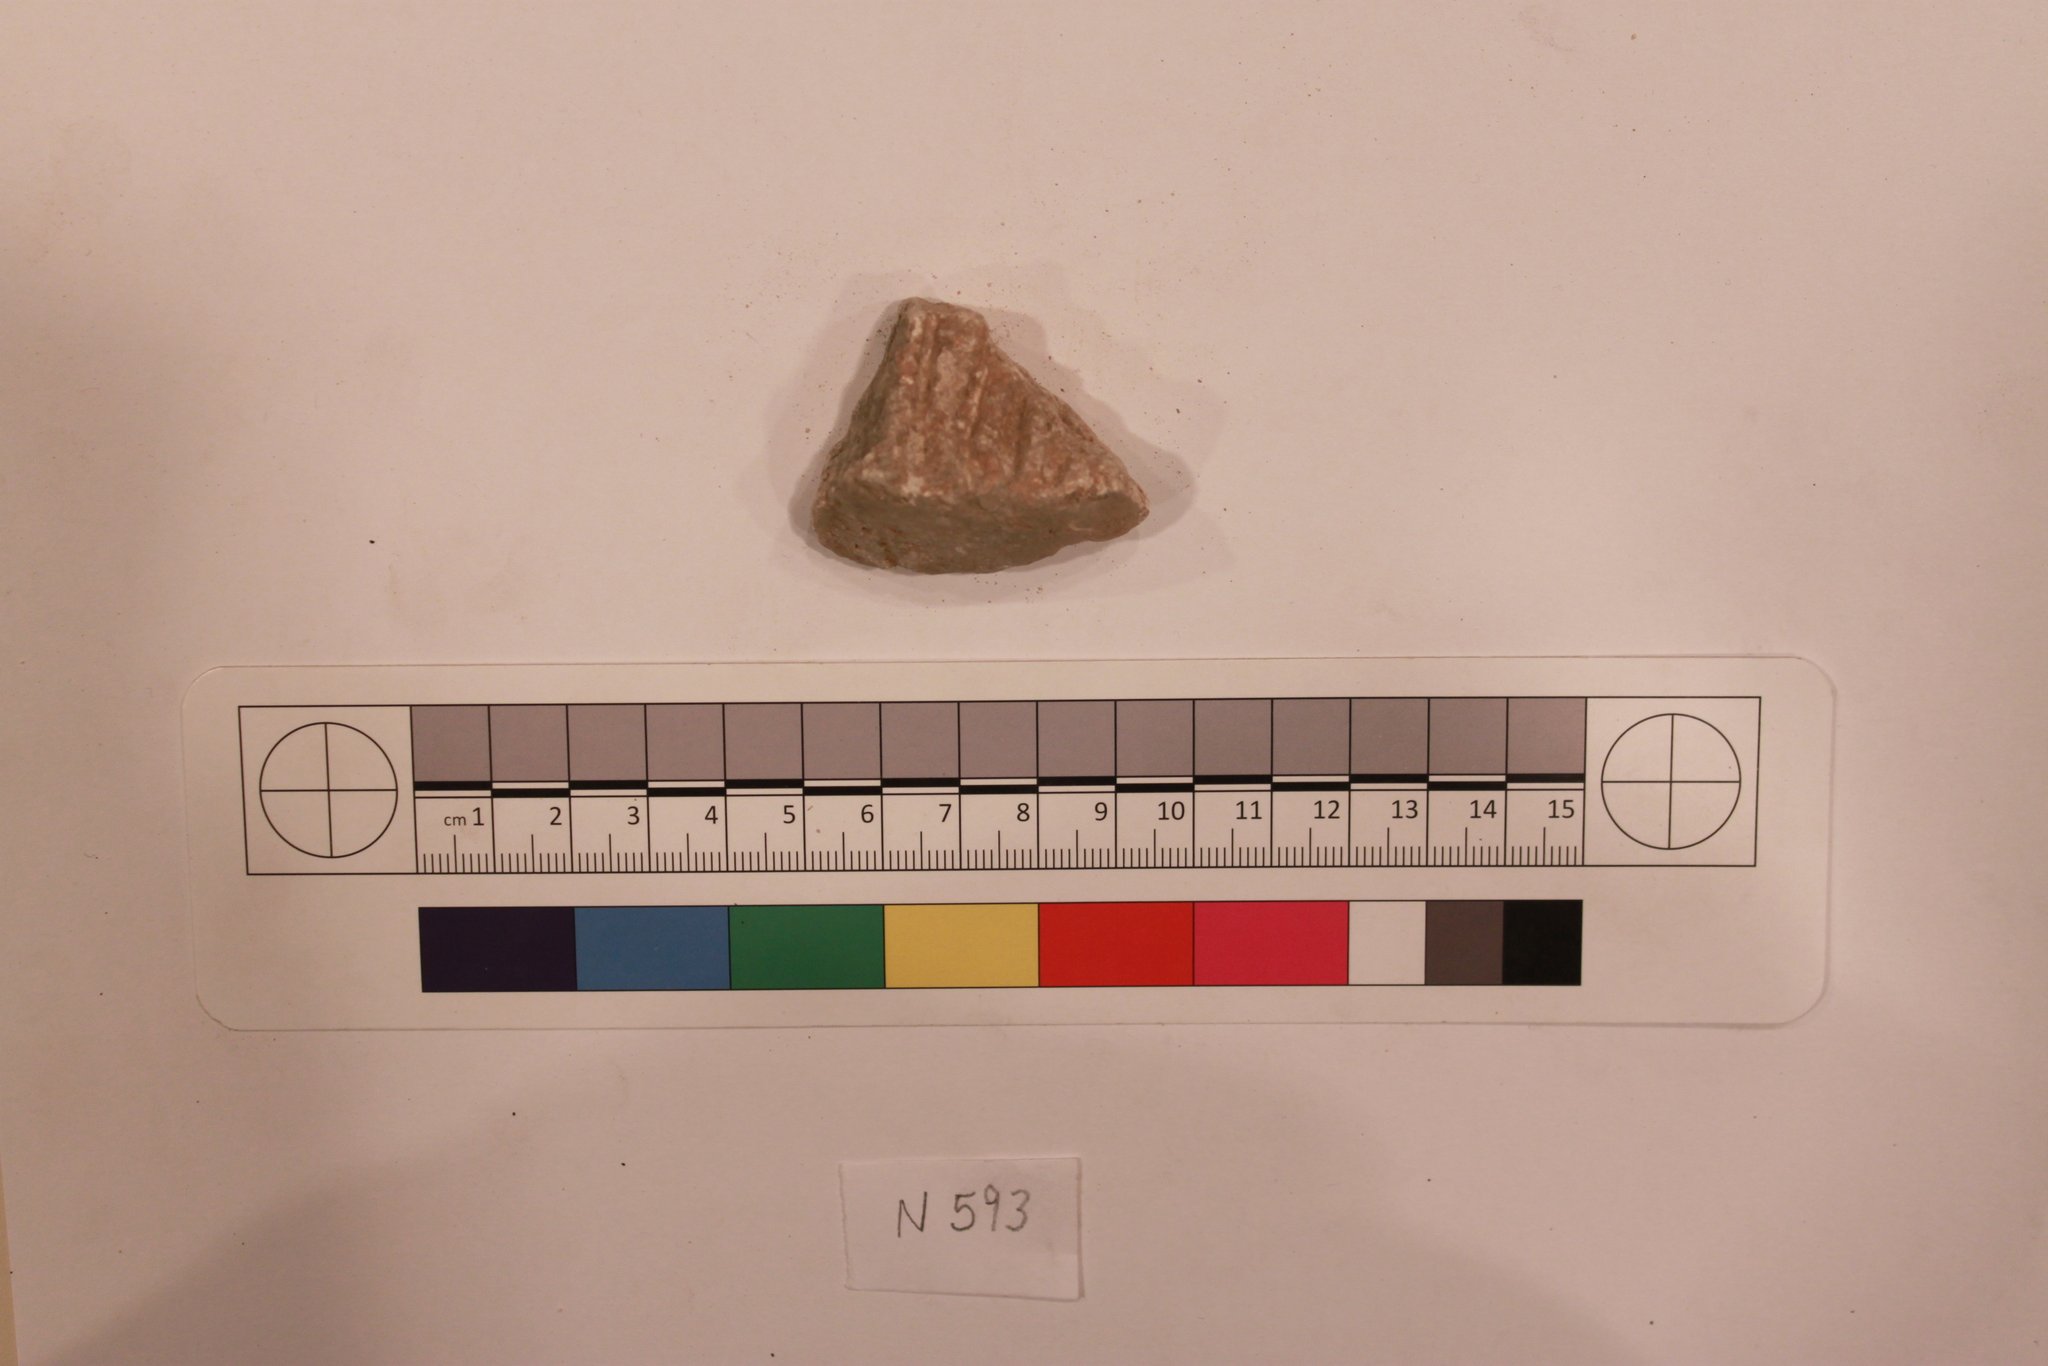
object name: fragment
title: Stucco Fragment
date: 701-1200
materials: plaster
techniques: carving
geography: iran